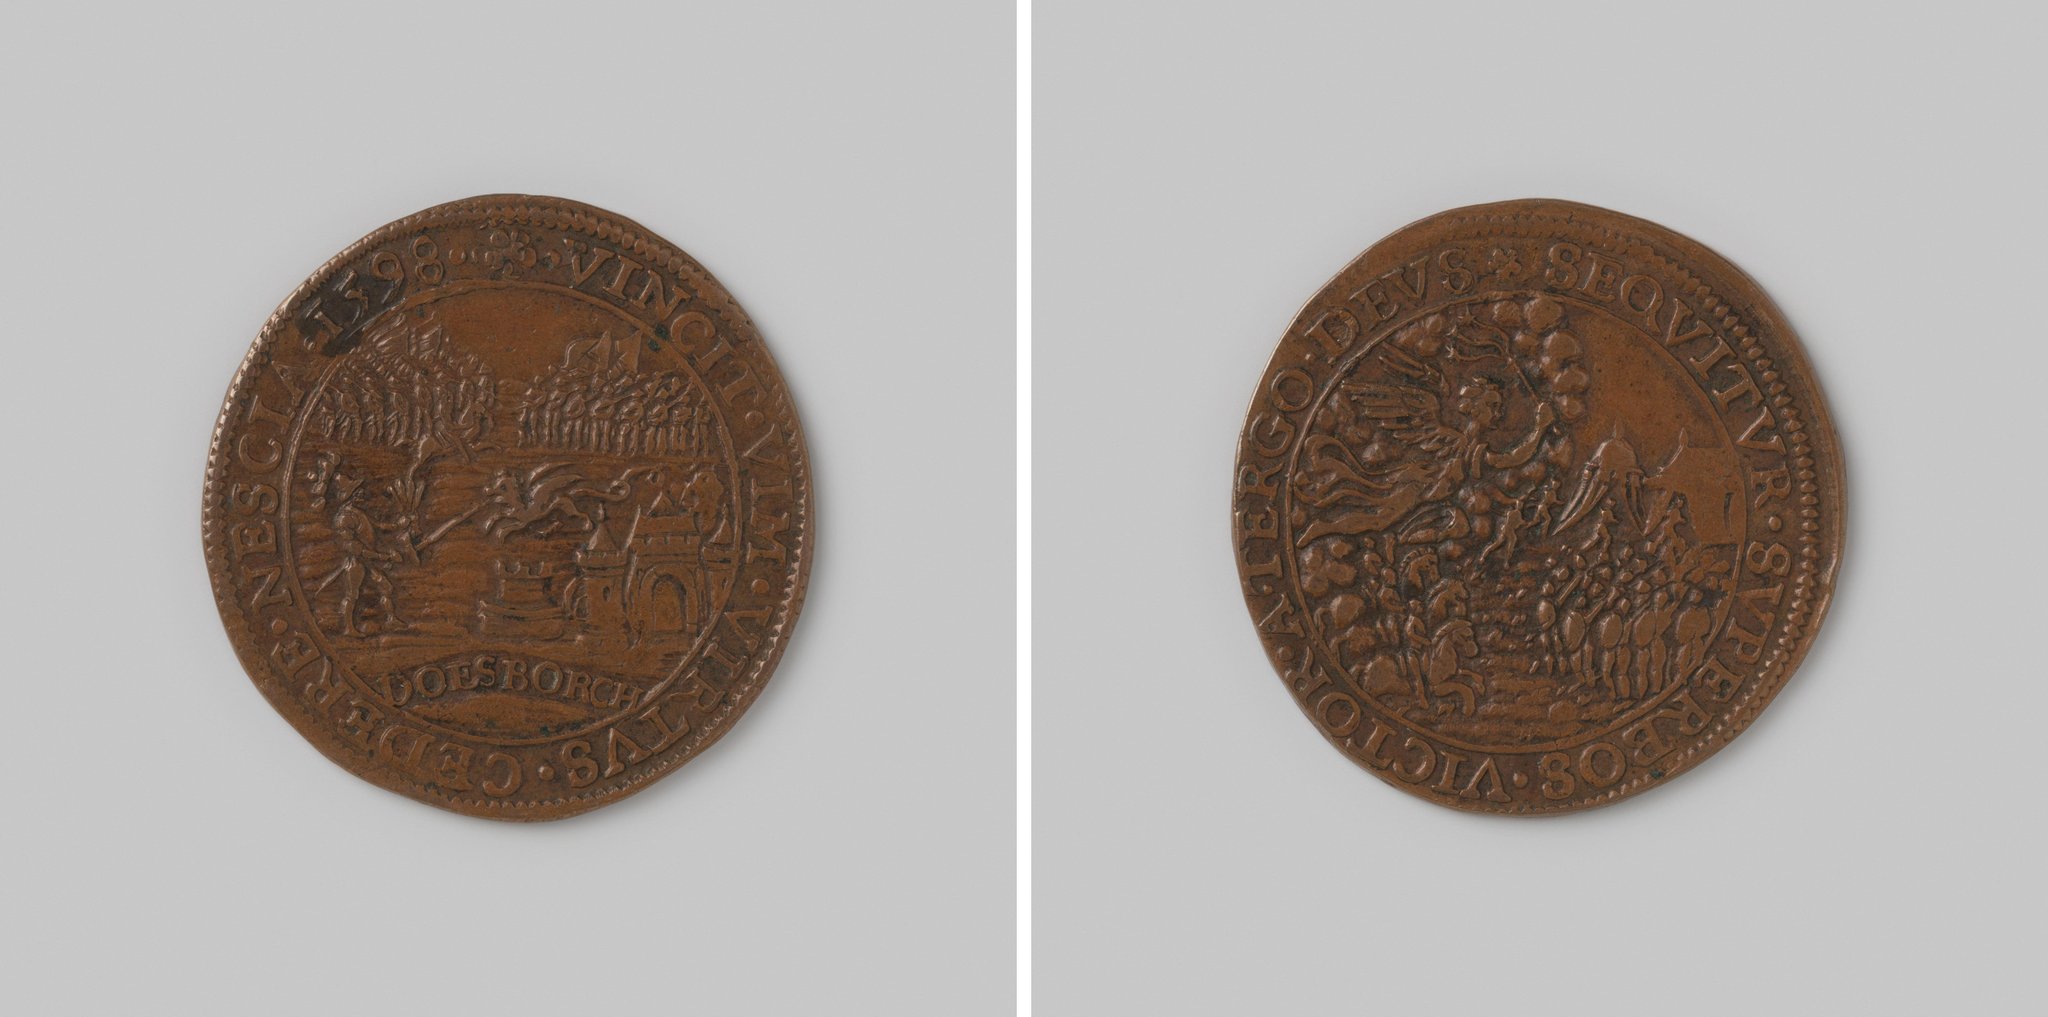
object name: jeton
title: Rekenpenning uit Dordrecht op de overwinning van Prins Maurits op Mendoça bij Doesburg 1598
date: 1598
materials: copper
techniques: striking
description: Koperen penning, op de voorzijde een soldaat met zwaard en pijlenbundel die voor de muren van Doesburg een draak bestrijdt, het leger op de achtergrond, met omschrift, op de keerzijde het vluchtende Spaanse leger achtervolgd door een geselende engel, met omschrift.